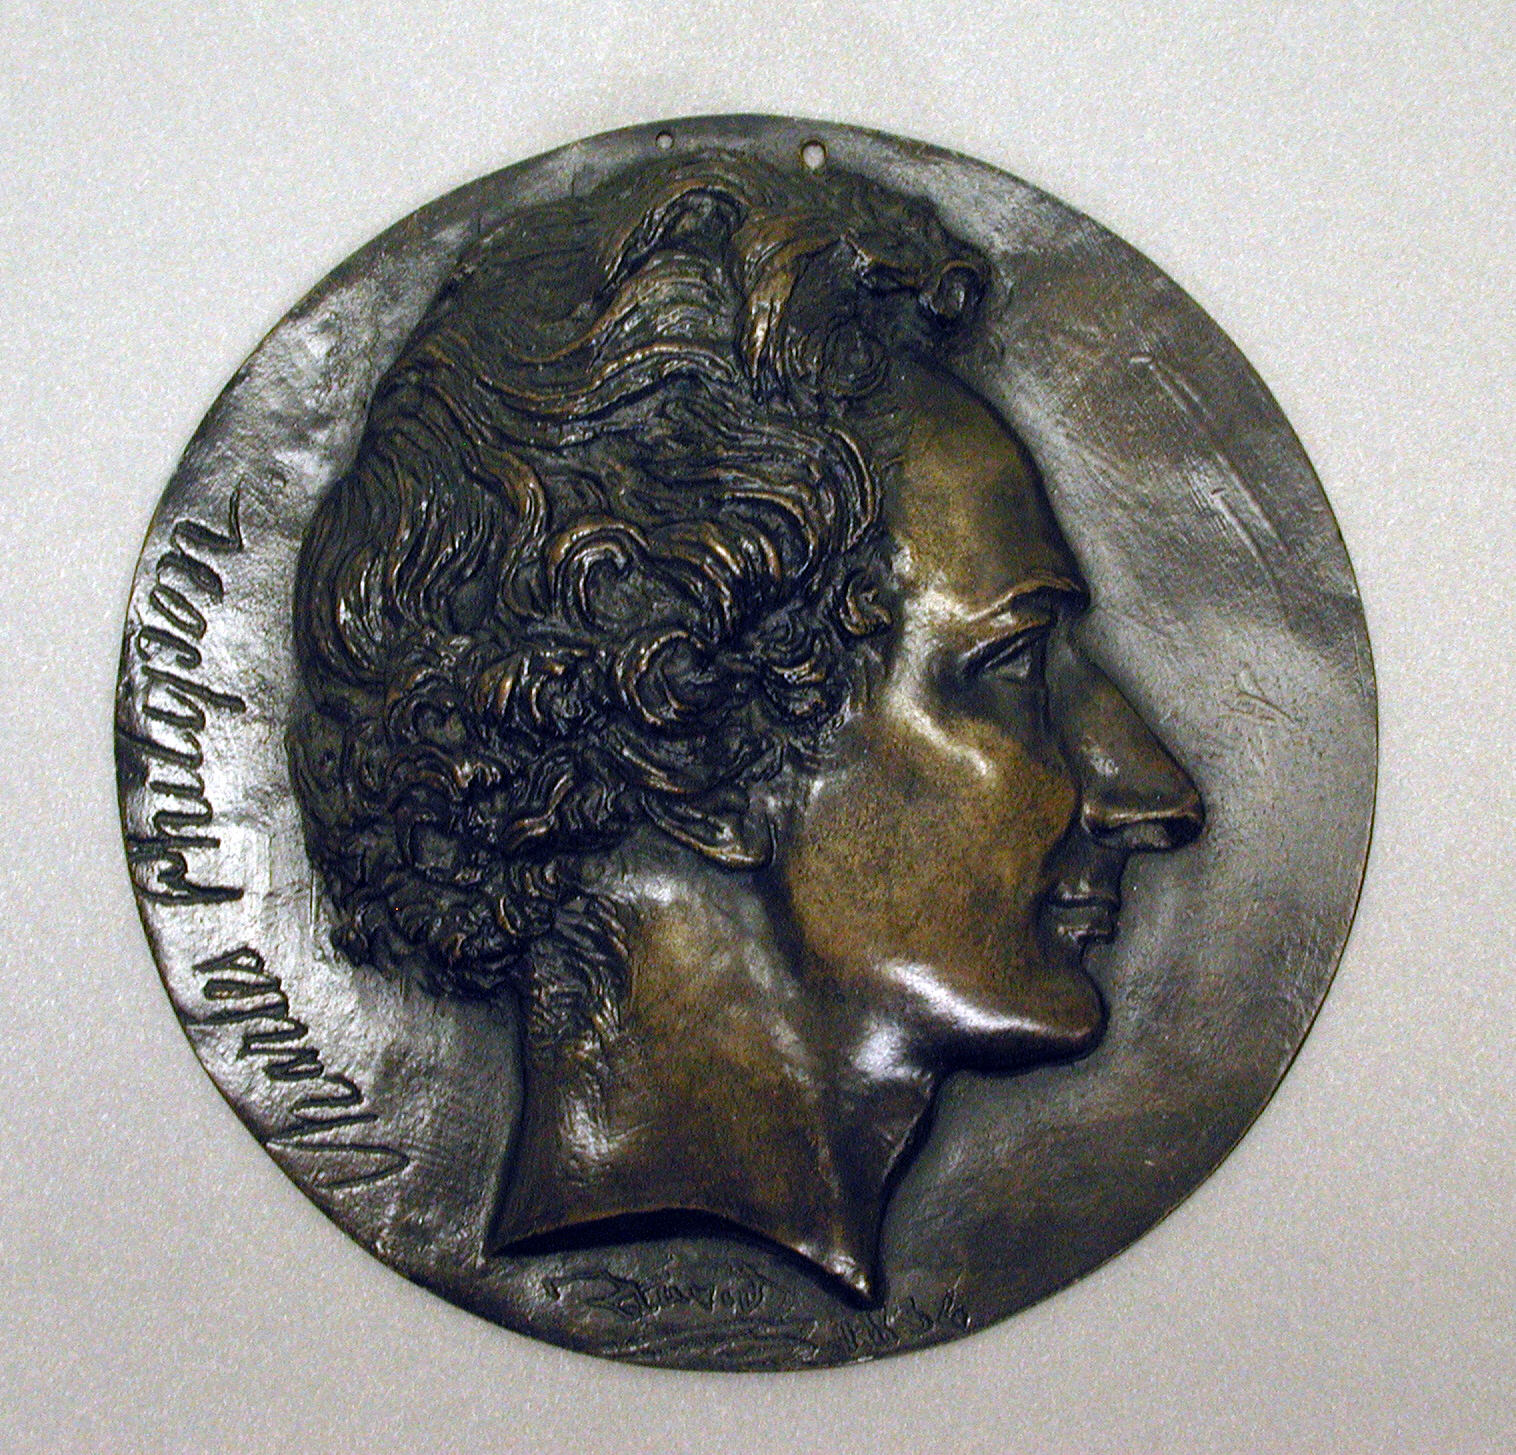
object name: medallion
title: Charles Philipon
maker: pierre jean david d'angers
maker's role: maker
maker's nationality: french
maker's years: 1788-1856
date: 1834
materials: bronze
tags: men,profiles